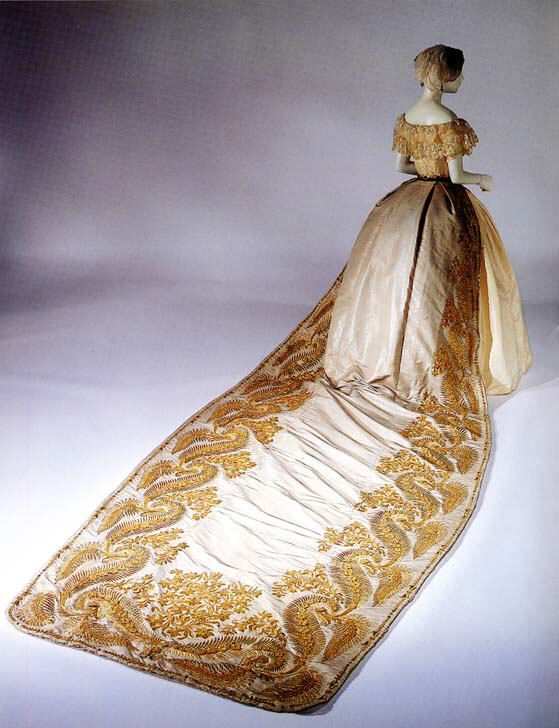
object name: court train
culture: british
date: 1850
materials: metal thread, silk